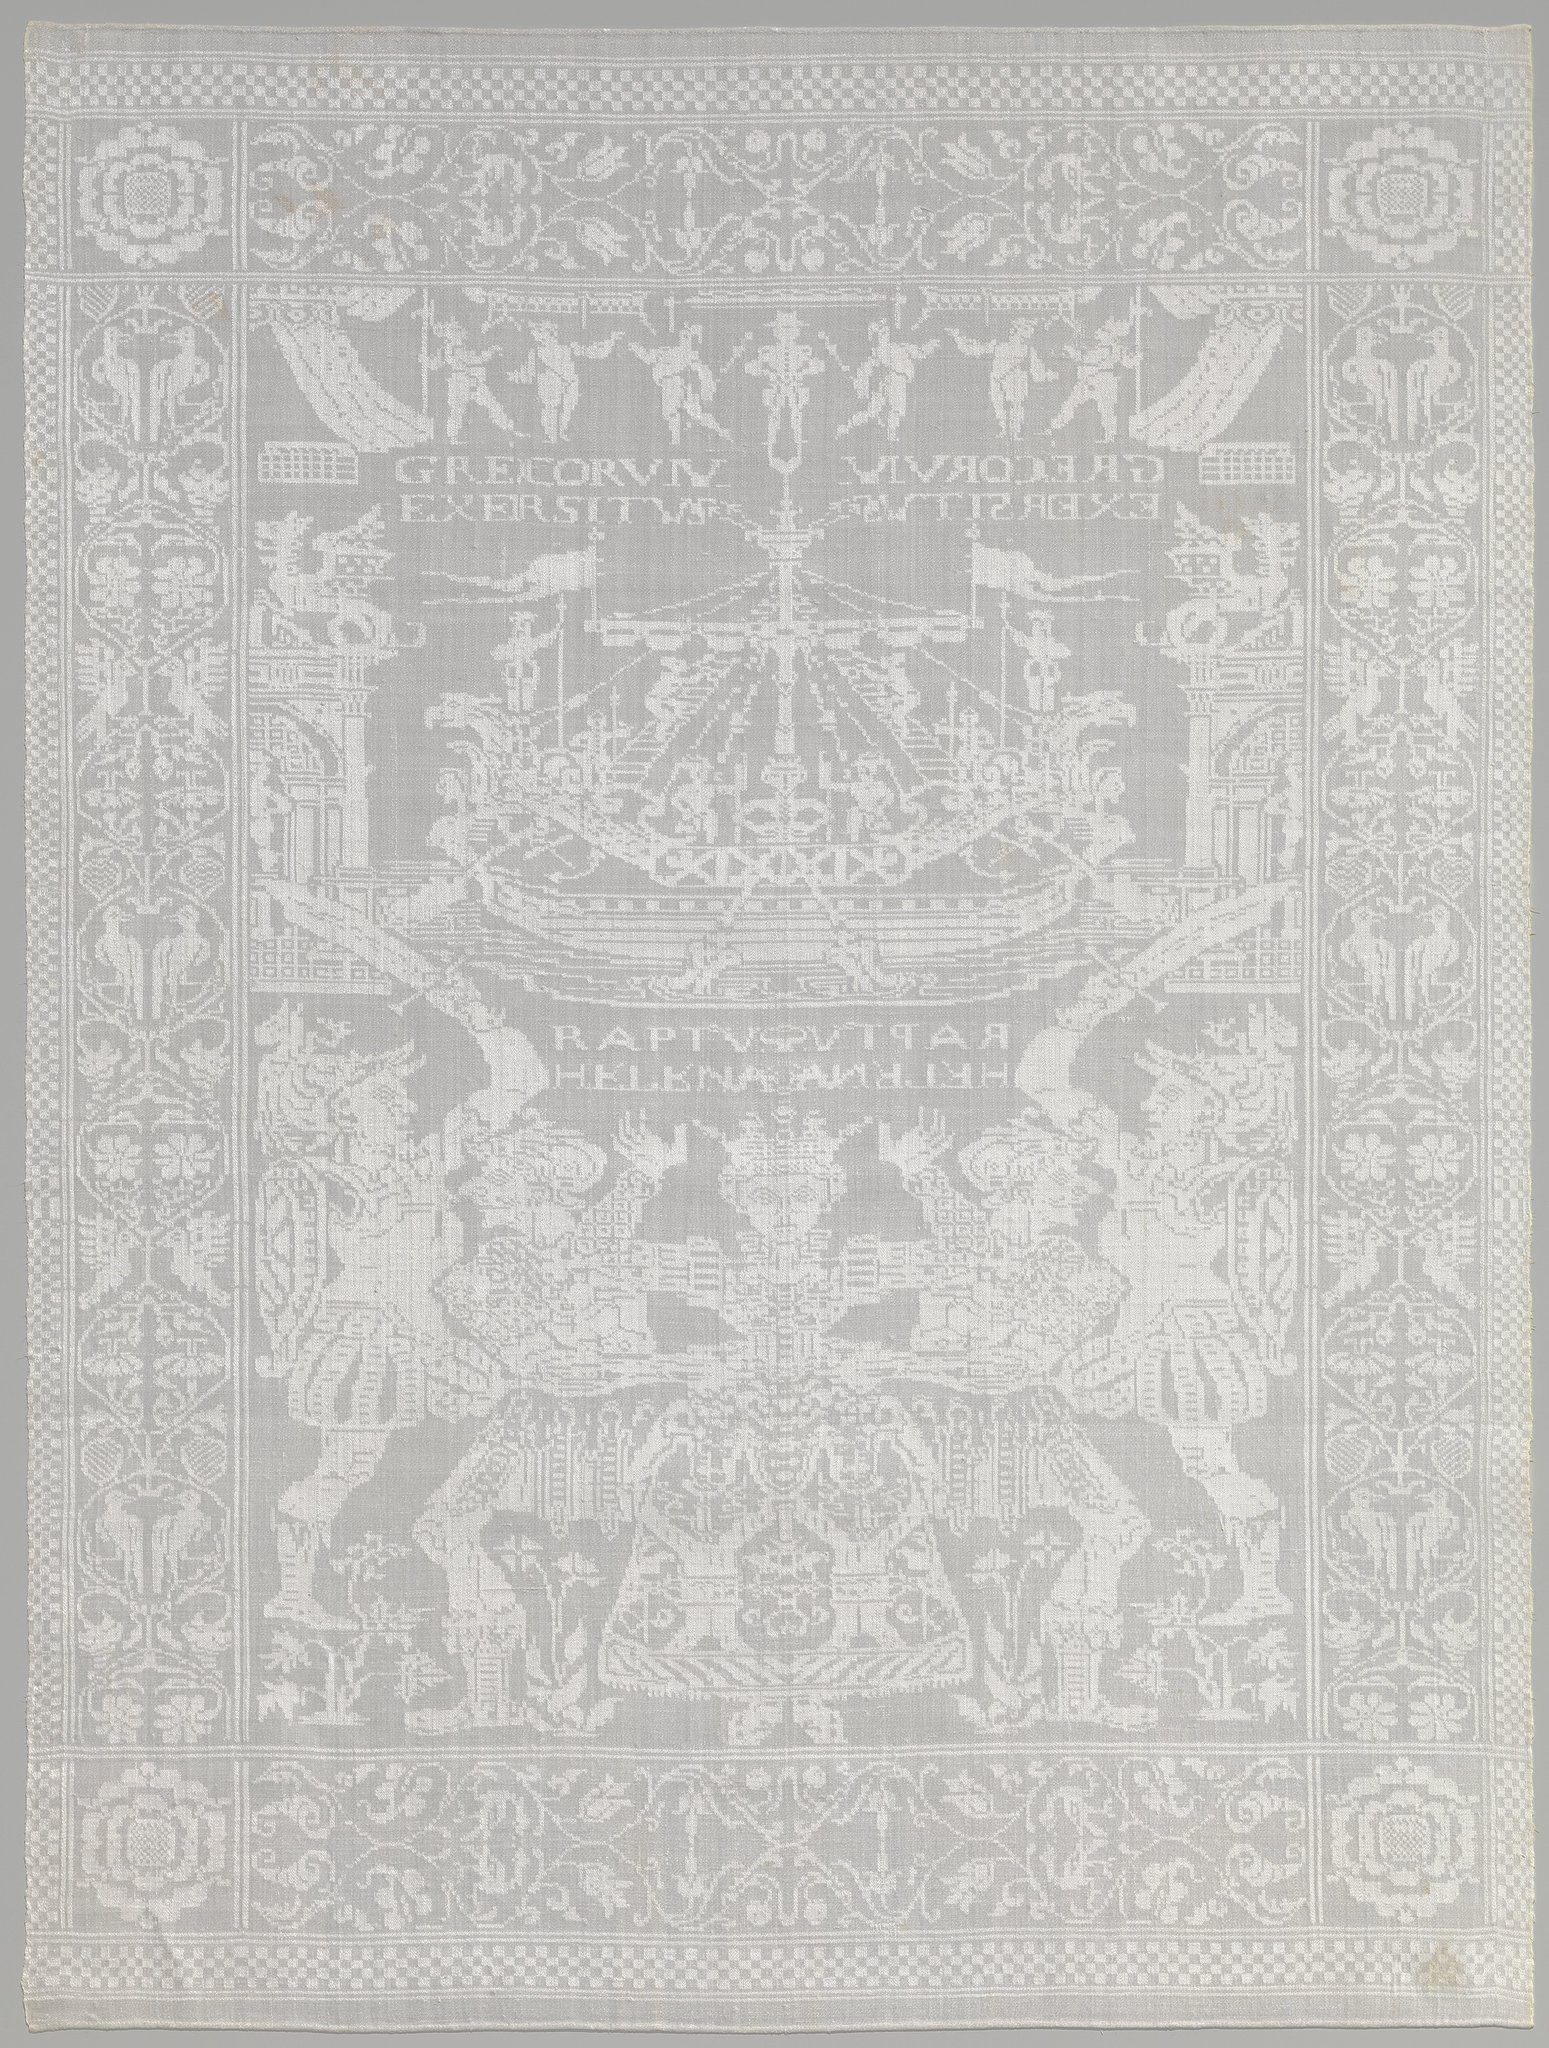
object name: napkin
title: Servet met verwoesting van Troje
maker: Anonymous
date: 1595-1625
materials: linen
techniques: damask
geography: haarlem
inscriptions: mark, mark: ‘kroon/ HW/ 23’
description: Wit linnen damasten servet met de verwoesting van Troje. Merk Kroon HW 23